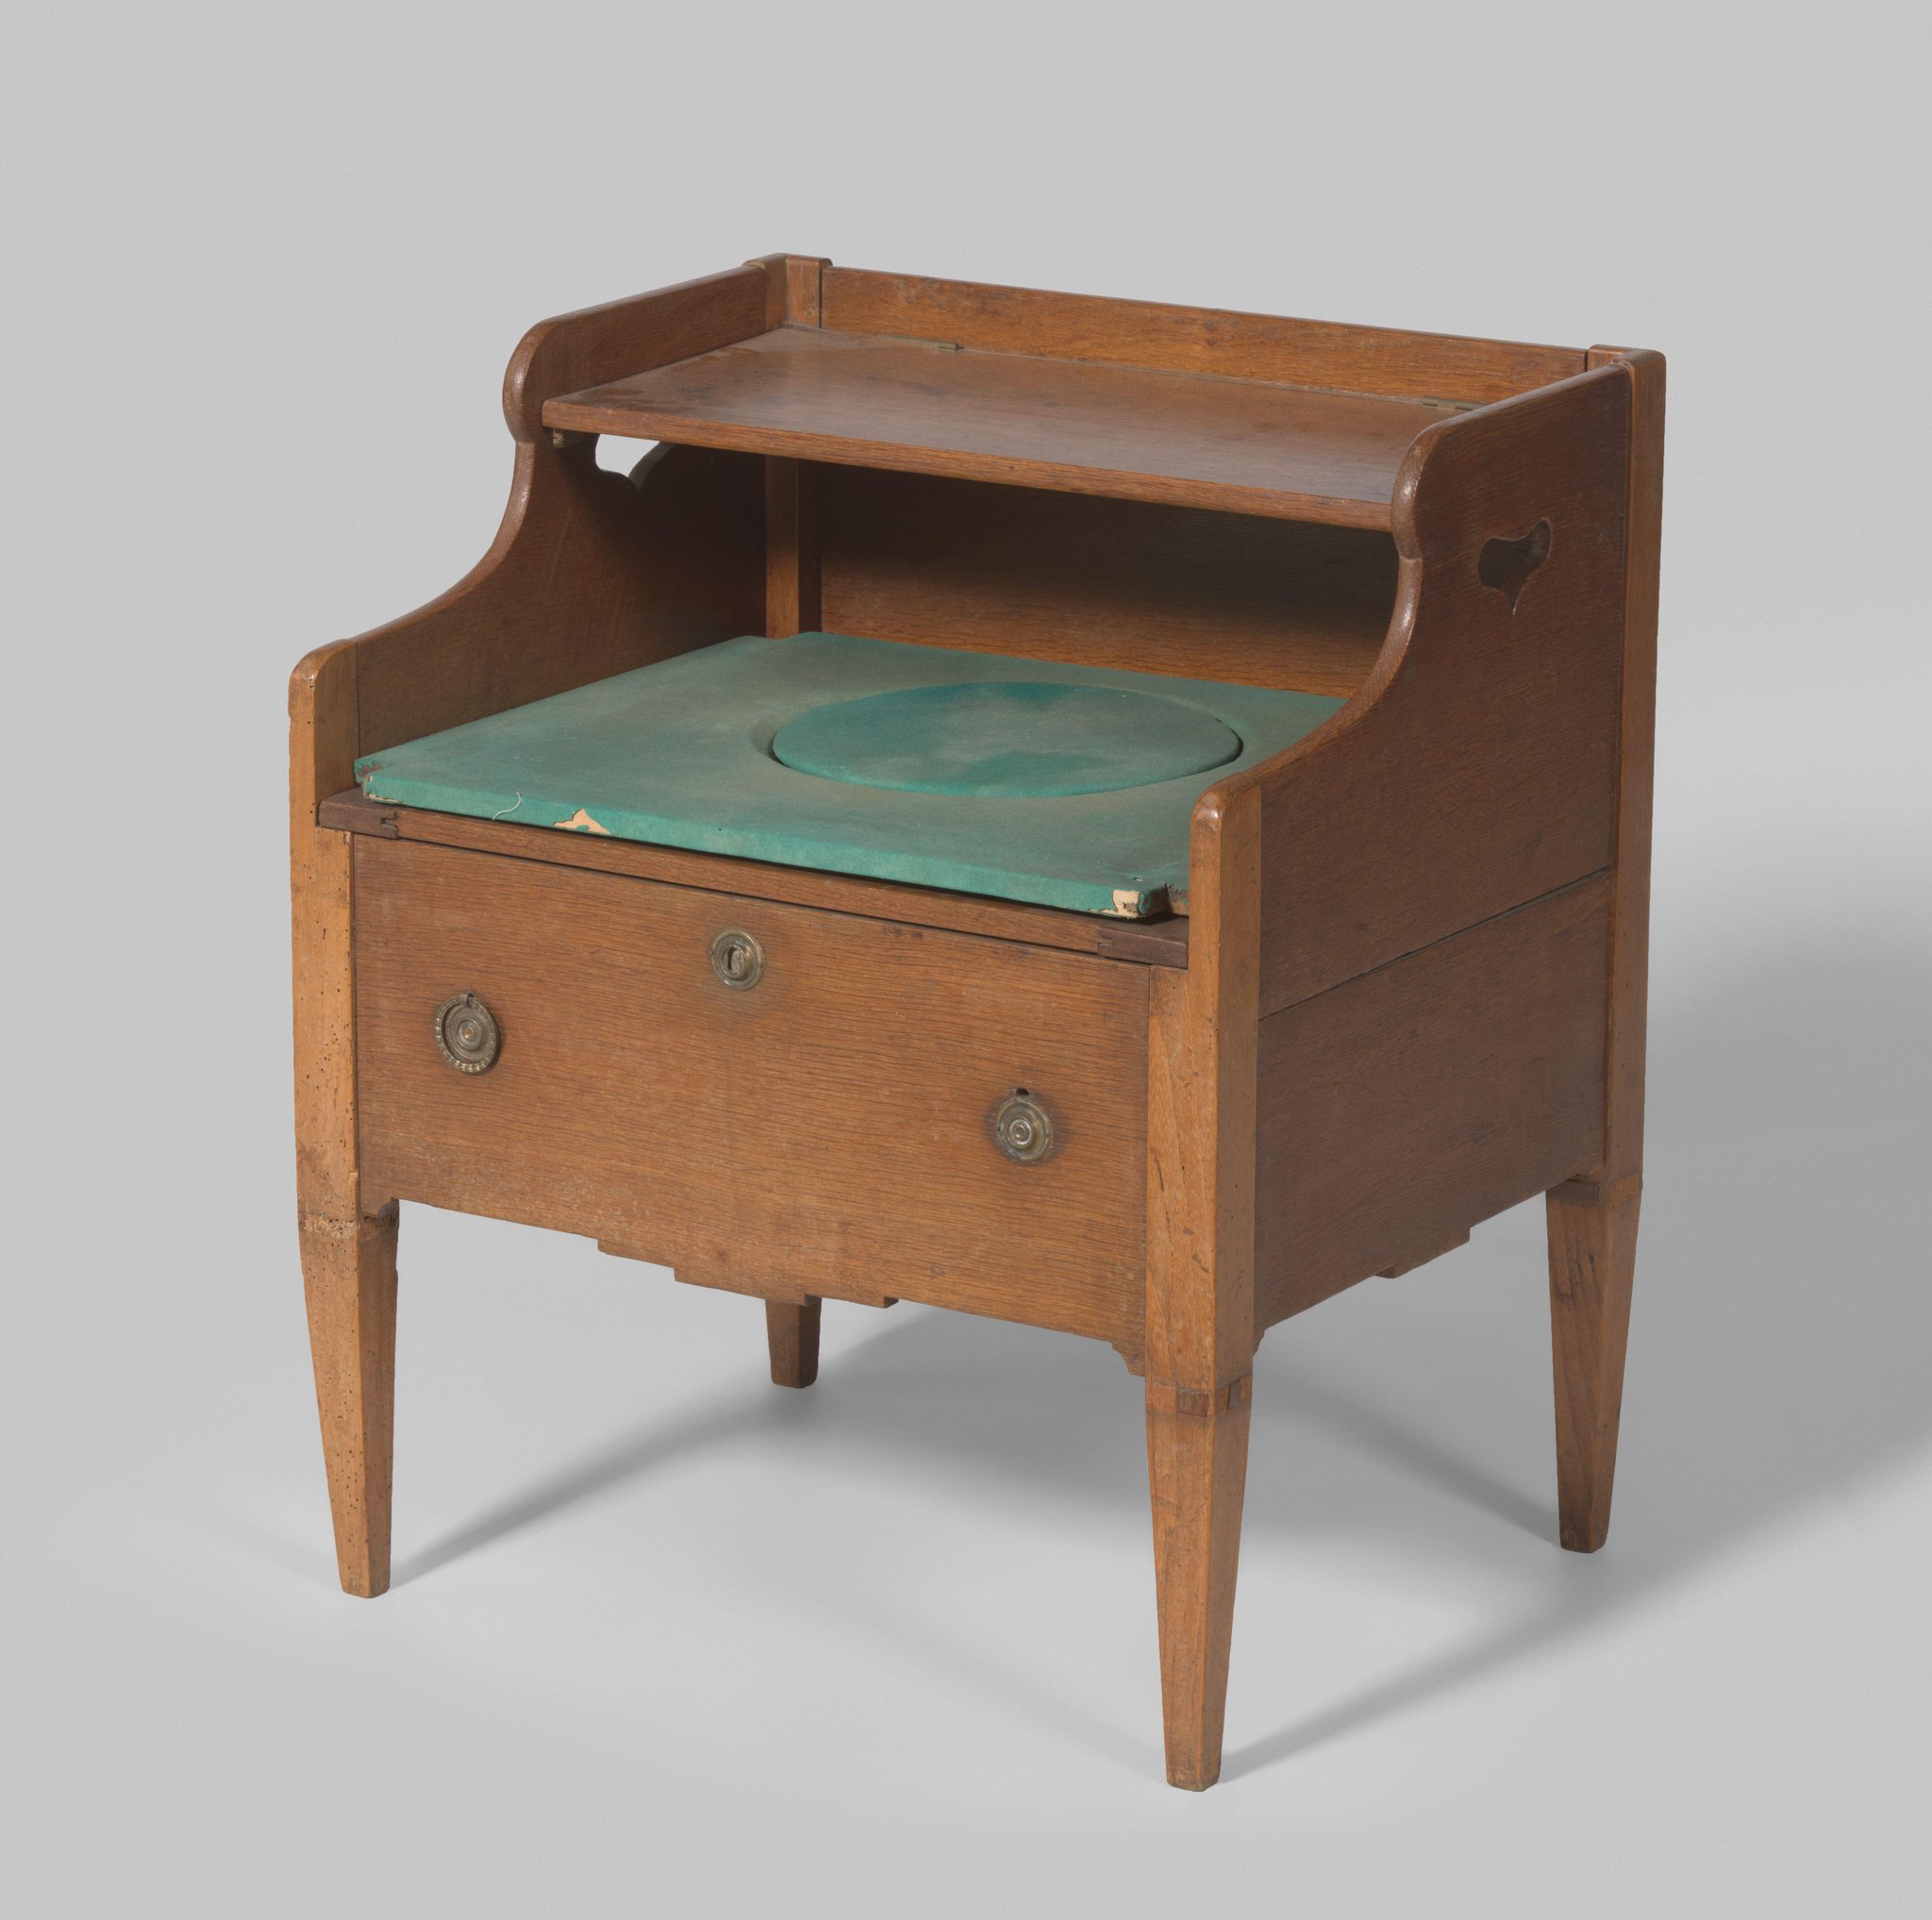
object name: furniture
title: Kamergemak voorzien van koperen trekkers en slotplaat en aan de binnenzijde bekleed met groen laken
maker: Anonymous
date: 1800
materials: copper, wood, textile, zinc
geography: northern netherlands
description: Kamergemak van eikenhout, rustend op vier conische poten en aan de voorzijde voorzien van twee koperen trekkers- en slotplaat. Het eigenlijke gemak, dat aan de binnenzijde bekleed is met groen laken, wordt afgesloten door een opklapbare plank; hierboven bevindt zich een, eveneens opklapbare, plank die smaller is.